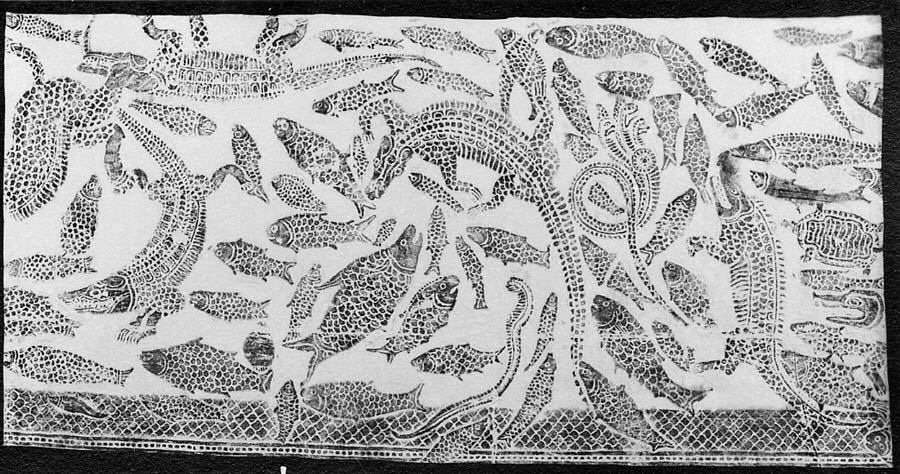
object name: rubbing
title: Rubbing of the Churning of the Sea of Milk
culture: cambodian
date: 1901-2000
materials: ink, paper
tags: fish